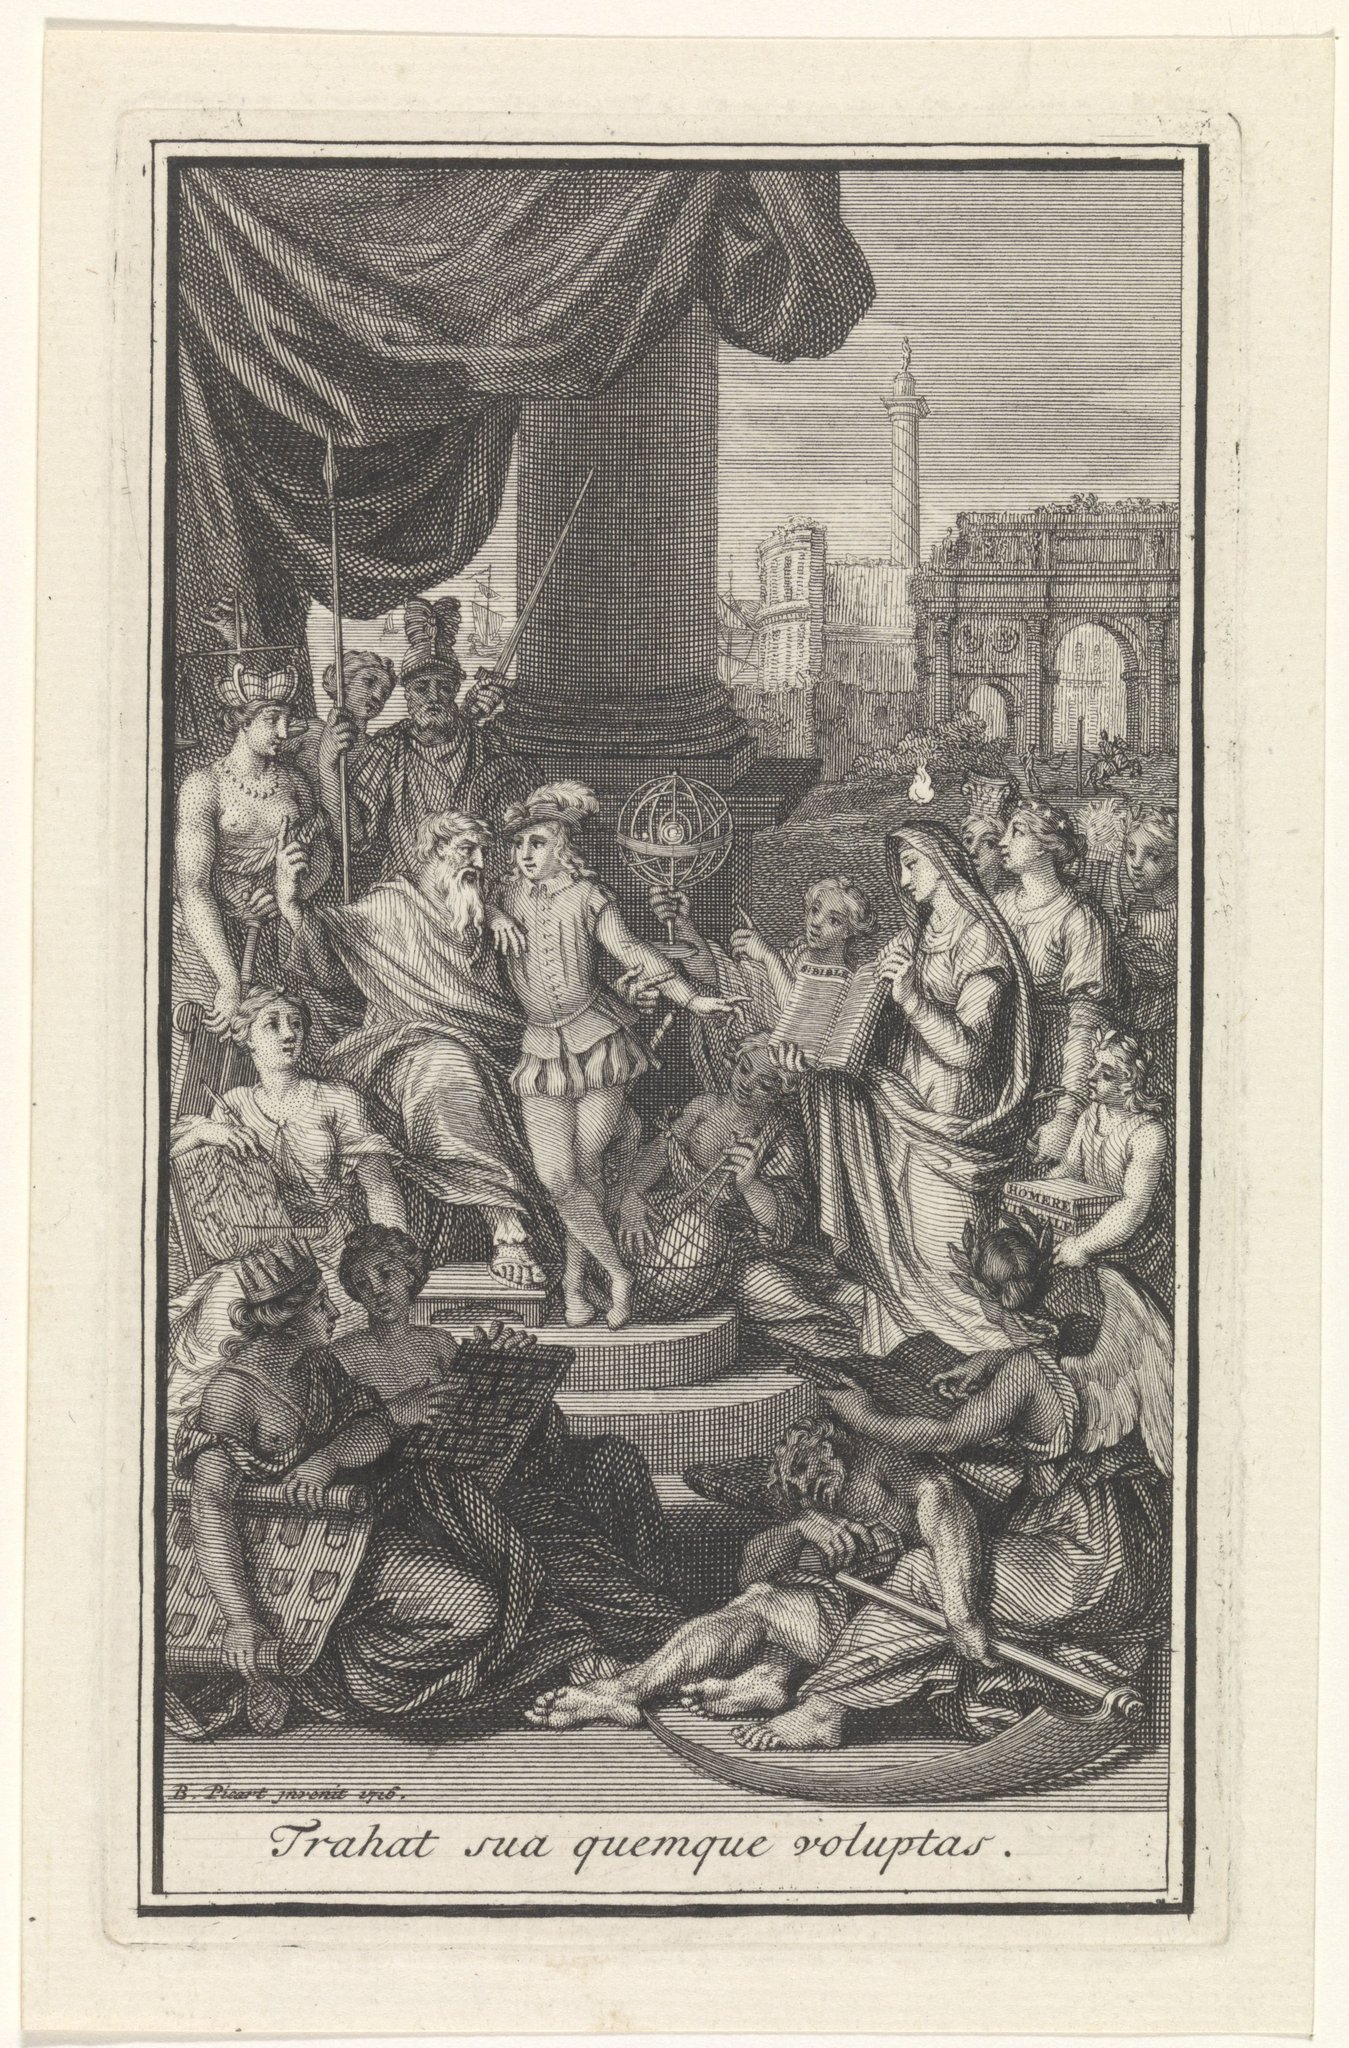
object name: print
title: Allegorische voorstelling met een oude man die naar de hemel wijst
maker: bernard picart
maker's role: draughtsman, print maker, publisher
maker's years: 1673-1733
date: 1716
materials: paper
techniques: engraving, etching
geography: amsterdam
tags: faith, 'fides'; 'fede', 'fede catholica', 'fede christiana', 'fede christiana catholica' (ripa) ~ one of the three theological virtues, the liberal arts together with other disciplines, family lineage, pedigree, genealogical tree or table, 'historia'; 'historia' (ripa), father time, man with wings and scythe, rome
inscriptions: collector's mark: Lugt 240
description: Allegorische voorstelling met op een verhoging een oude man die naar de hemel wijst. Een jonge edelman omarmt hem en wijst op de bijbel die door Geloof wordt vastgehouden. Ze worden omringd door de zeven vrije kunsten. Linksachter een riviergodin, Rechtvaardigheid en Mars. Links op de voorgrond Genealogie en Chronologie. Rechts op de voorgrond Geschiedenis en Vader Tijd die in slaap is gevallen. Op de achtergrond een gezicht op enkele monumenten uit Rome. In de marge een devies in het Latijn (Trahat sua quemque voluptas).